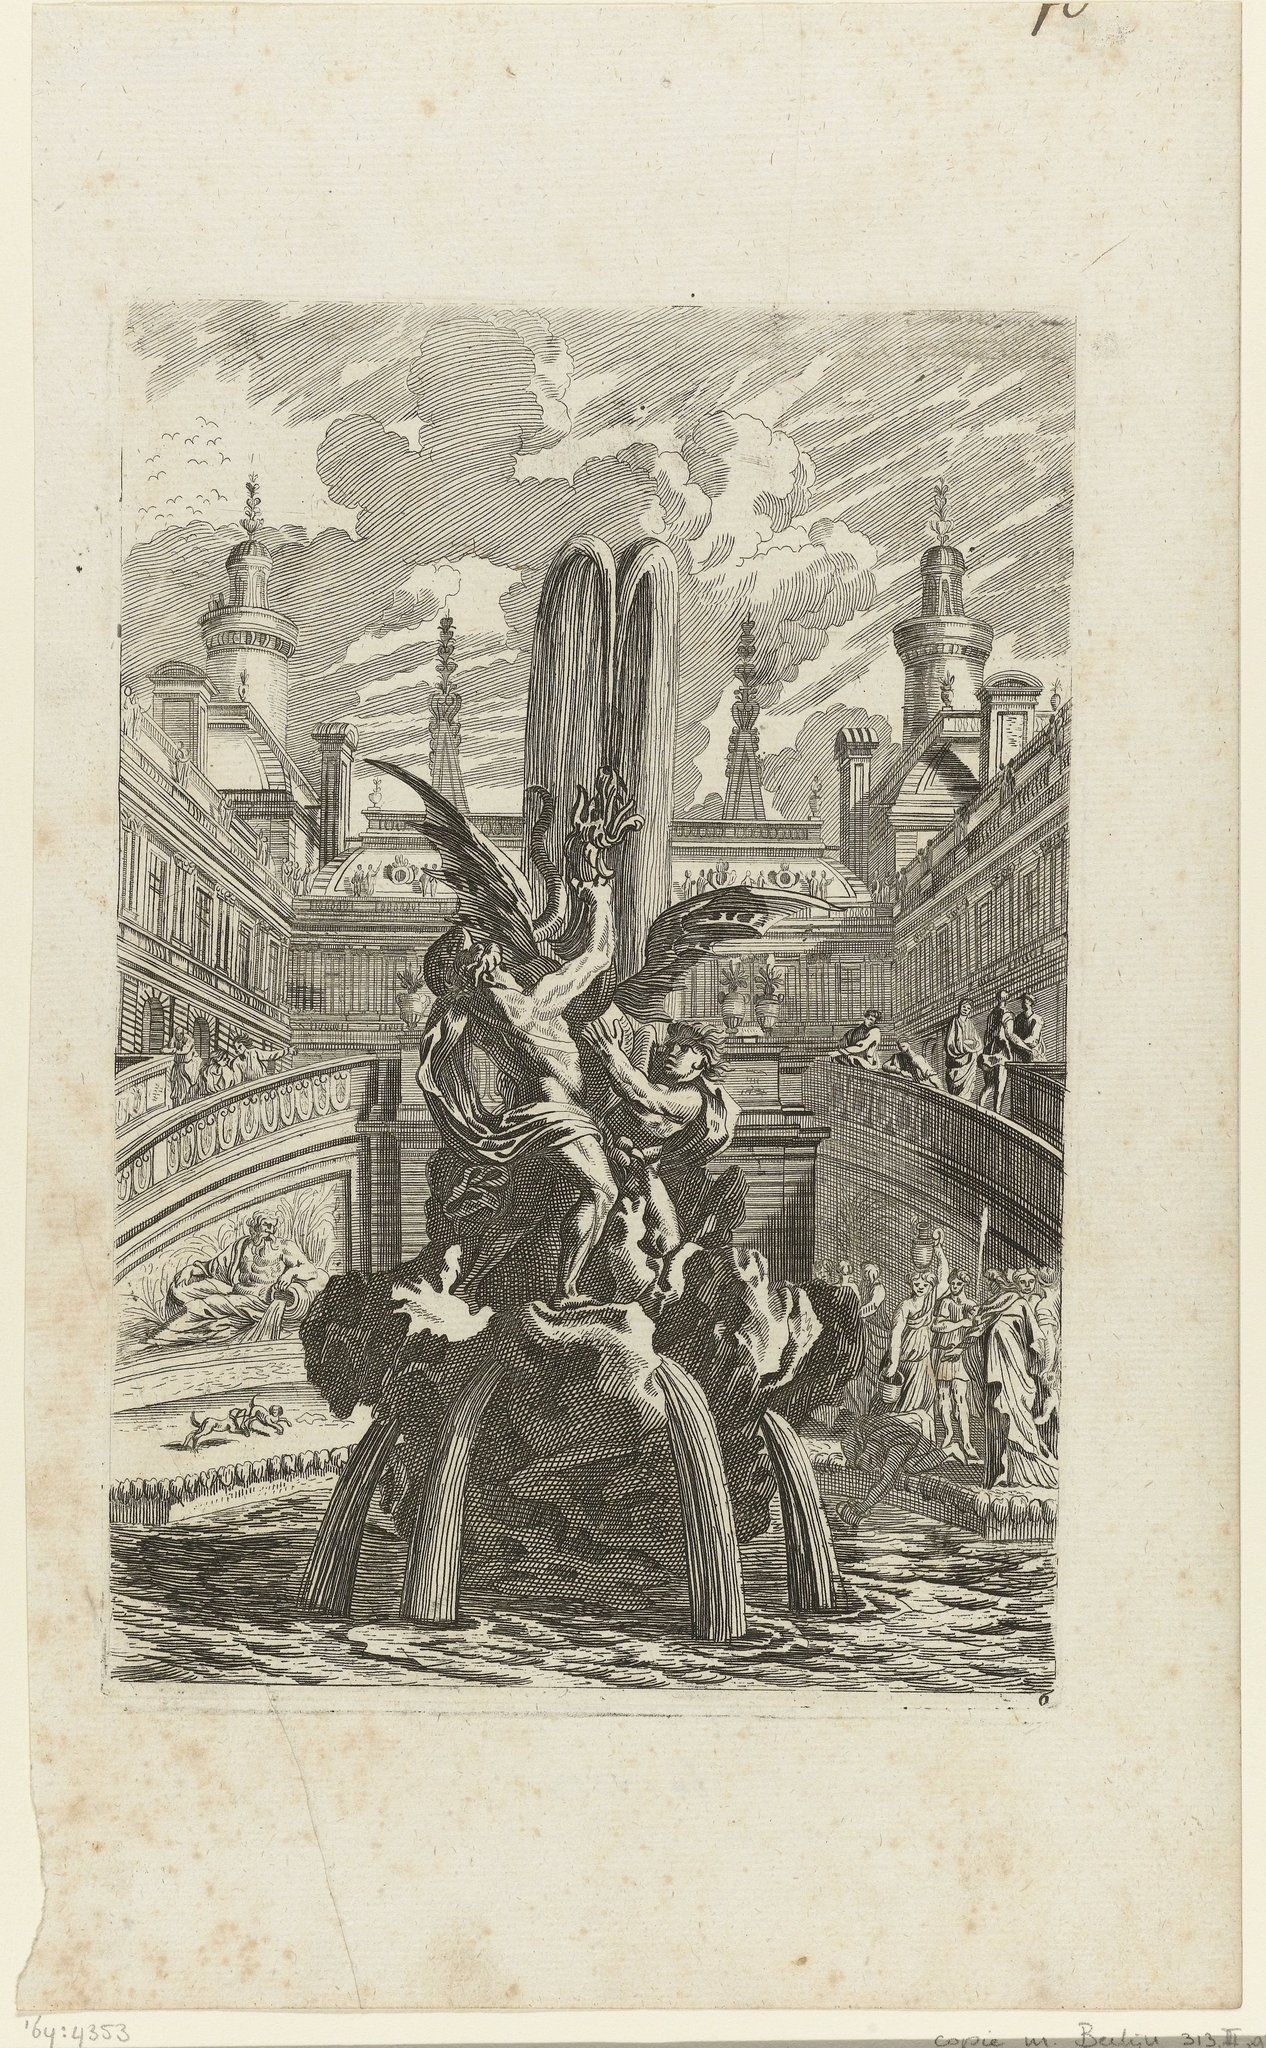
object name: ornament print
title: Fontein met twee mannen die een draak vasthouden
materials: paper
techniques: etching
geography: augsburg